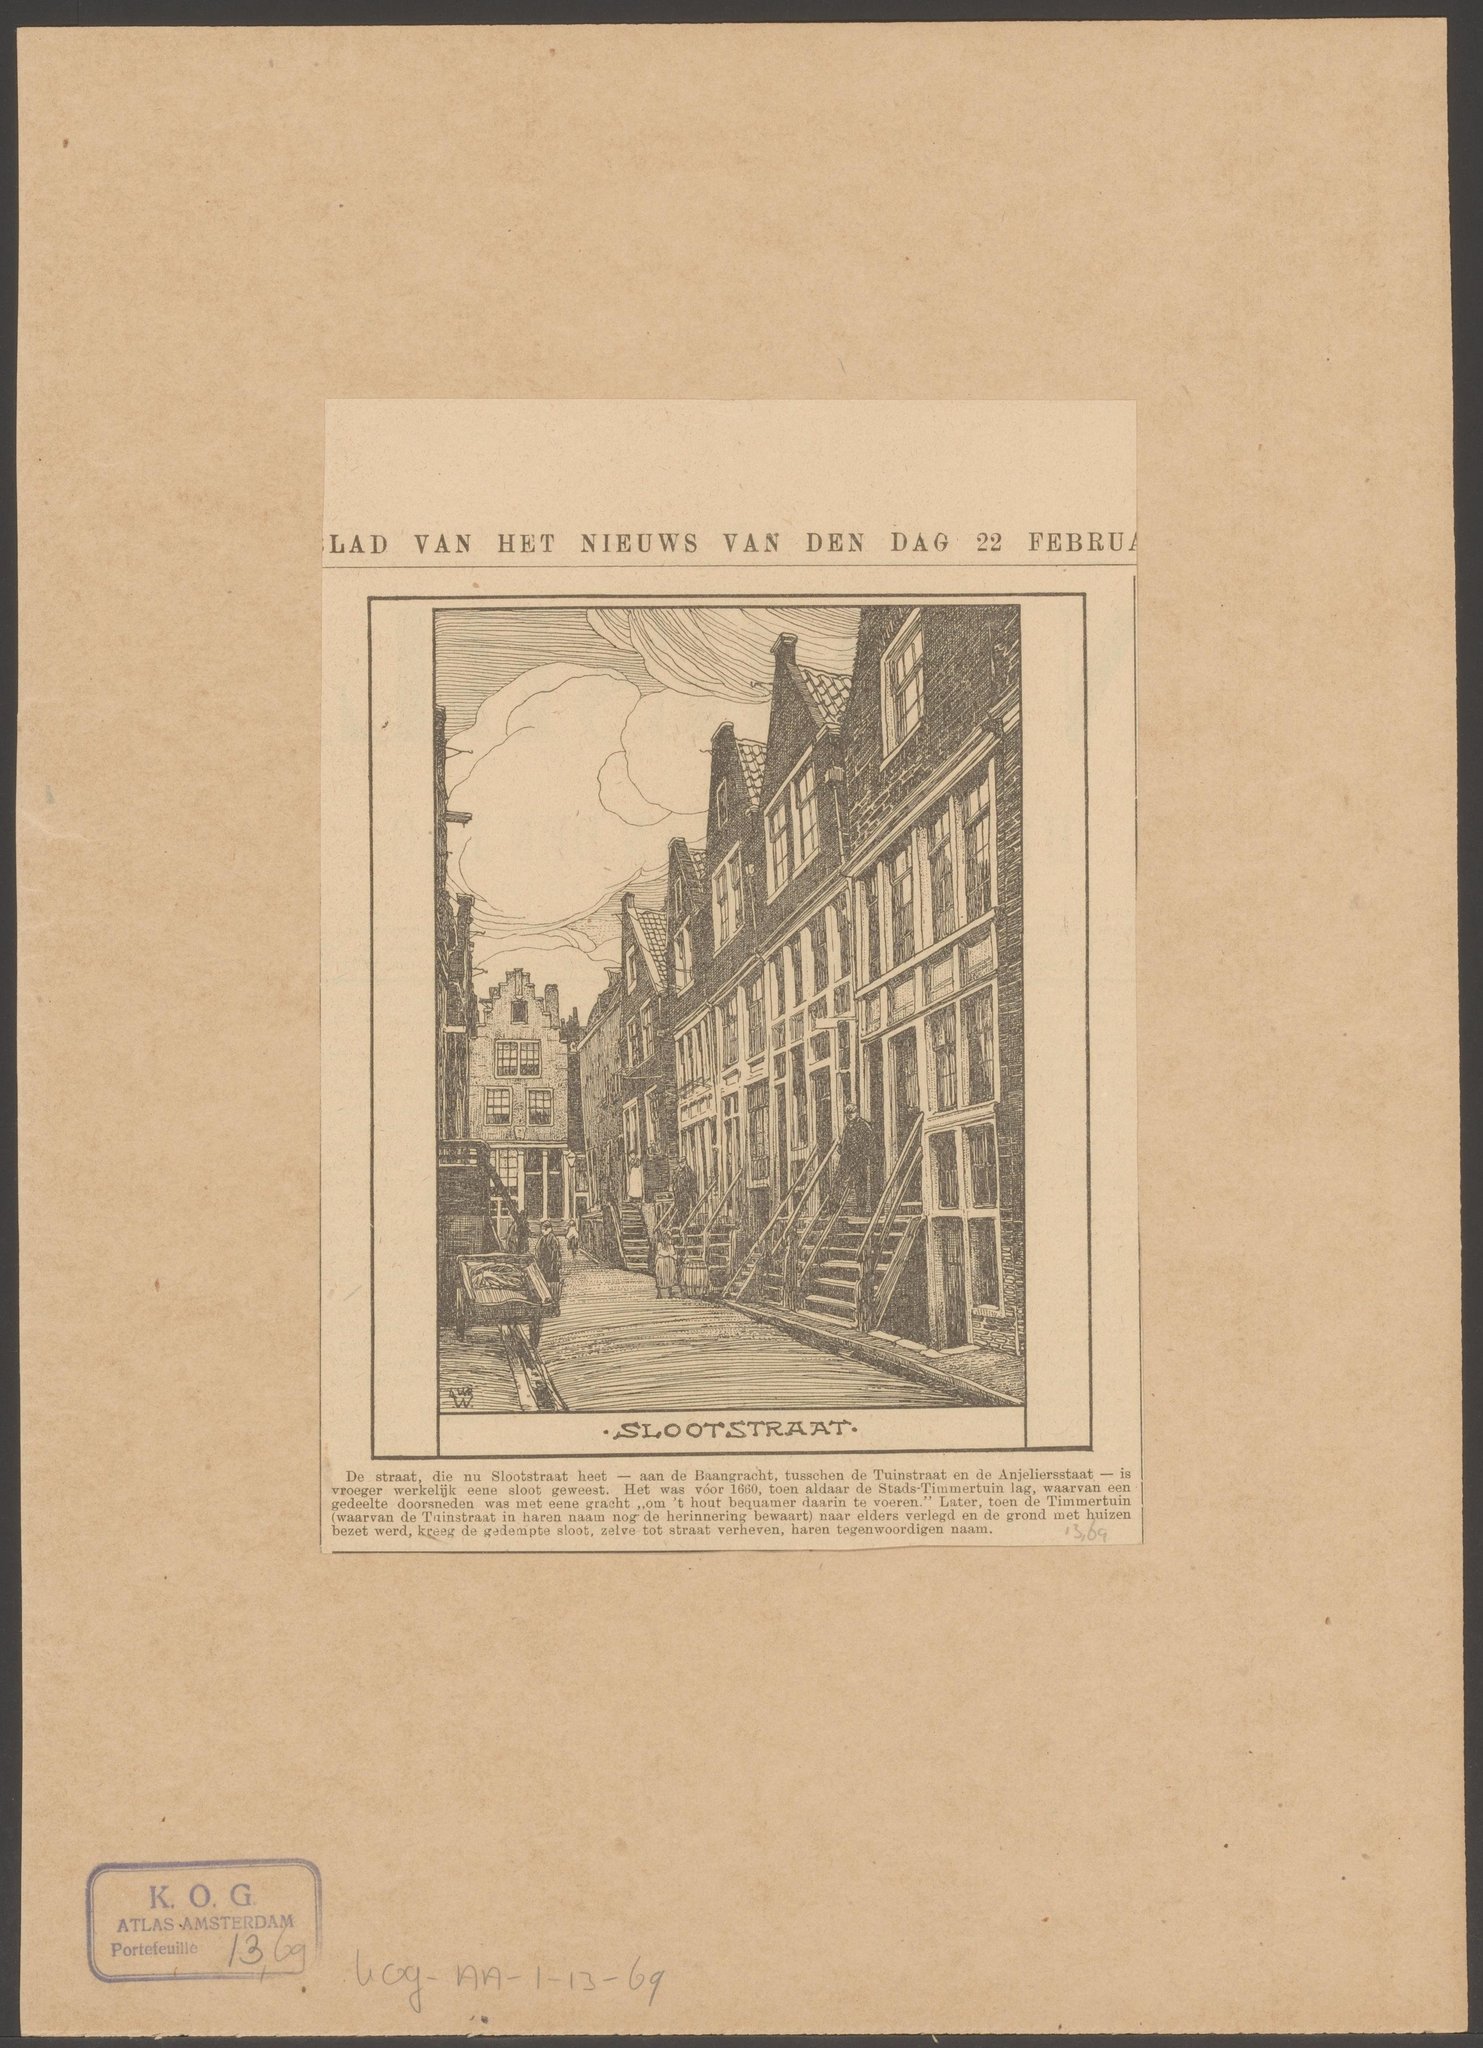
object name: page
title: Oud-Amsterdam 100 Stadsgezichten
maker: willem wenckebach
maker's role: designer, draughtsman, painter, print maker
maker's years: 1860-1937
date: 1870-1923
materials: paper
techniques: letterpress printing, line block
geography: amsterdam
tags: city-view in general; 'veduta', the usual house or row of houses, street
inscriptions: collector's mark: ‘13,69’ Lugt 1641b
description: Onderwerpsrubriek binnen de Atlas Amsterdam: Slatuinenpad, Sloterkade, Slootstraat, Slijkstraat, Snoekjesgracht, Sophiapark, Spaarndammerdijk, Spiegelgracht, Spinhuissteeg, Spui, Spuistraat (ook lage Erf), Staalstraat, Stadhouderskade, Steenpad, Stroomarkt.